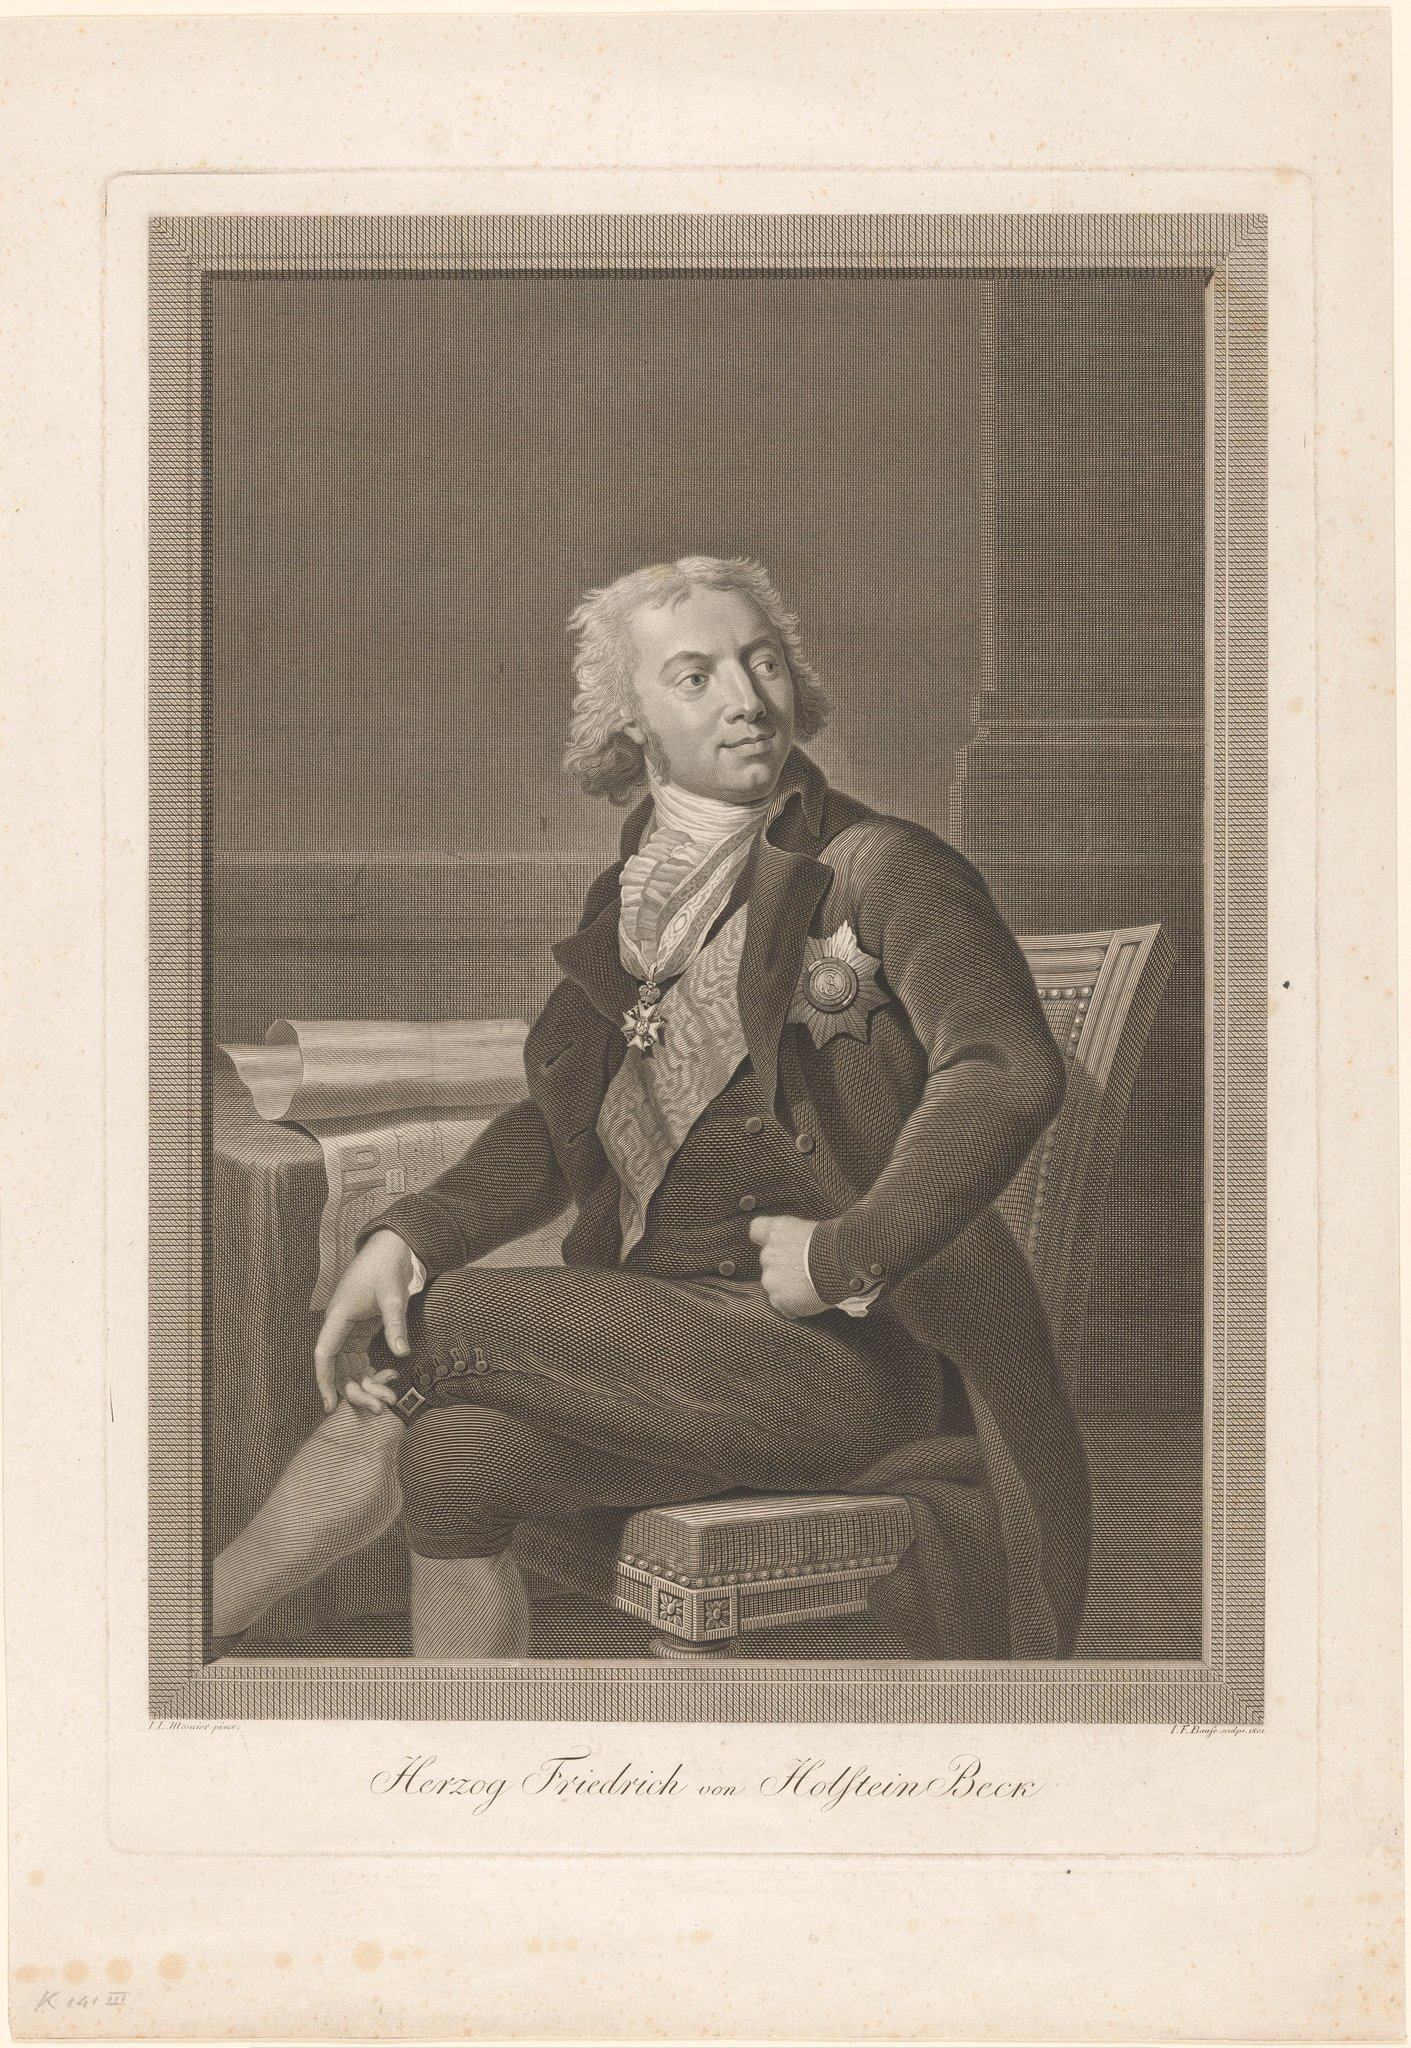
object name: print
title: Portret van Friedrich Karl Ludwig, hertog van Schlweswig-Holstein-Sonderburg-Beck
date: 1801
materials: paper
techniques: engraving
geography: leipzig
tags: historical persons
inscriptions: collector's mark: Lugt 2228